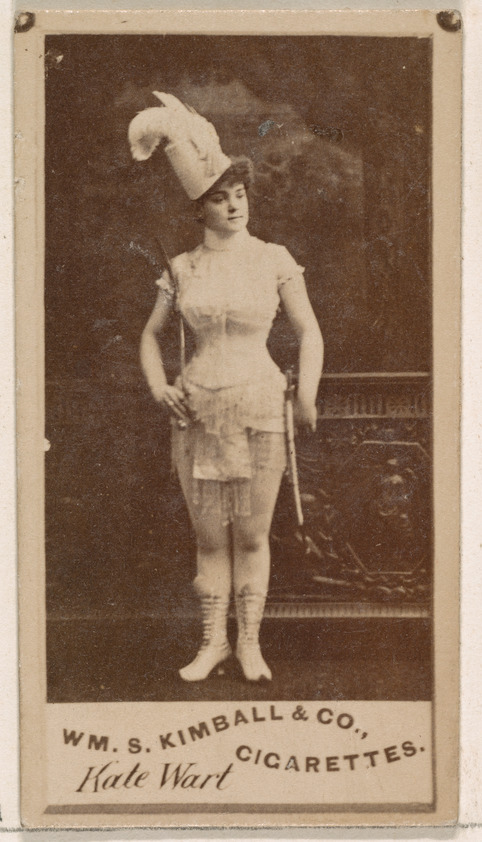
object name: photograph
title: Kate Wart, from the Actresses series (N203) issued by Wm. S. Kimball & Co.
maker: william s. kimball & company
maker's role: publisher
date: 1889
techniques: color lithograph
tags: portraits,women,actresses